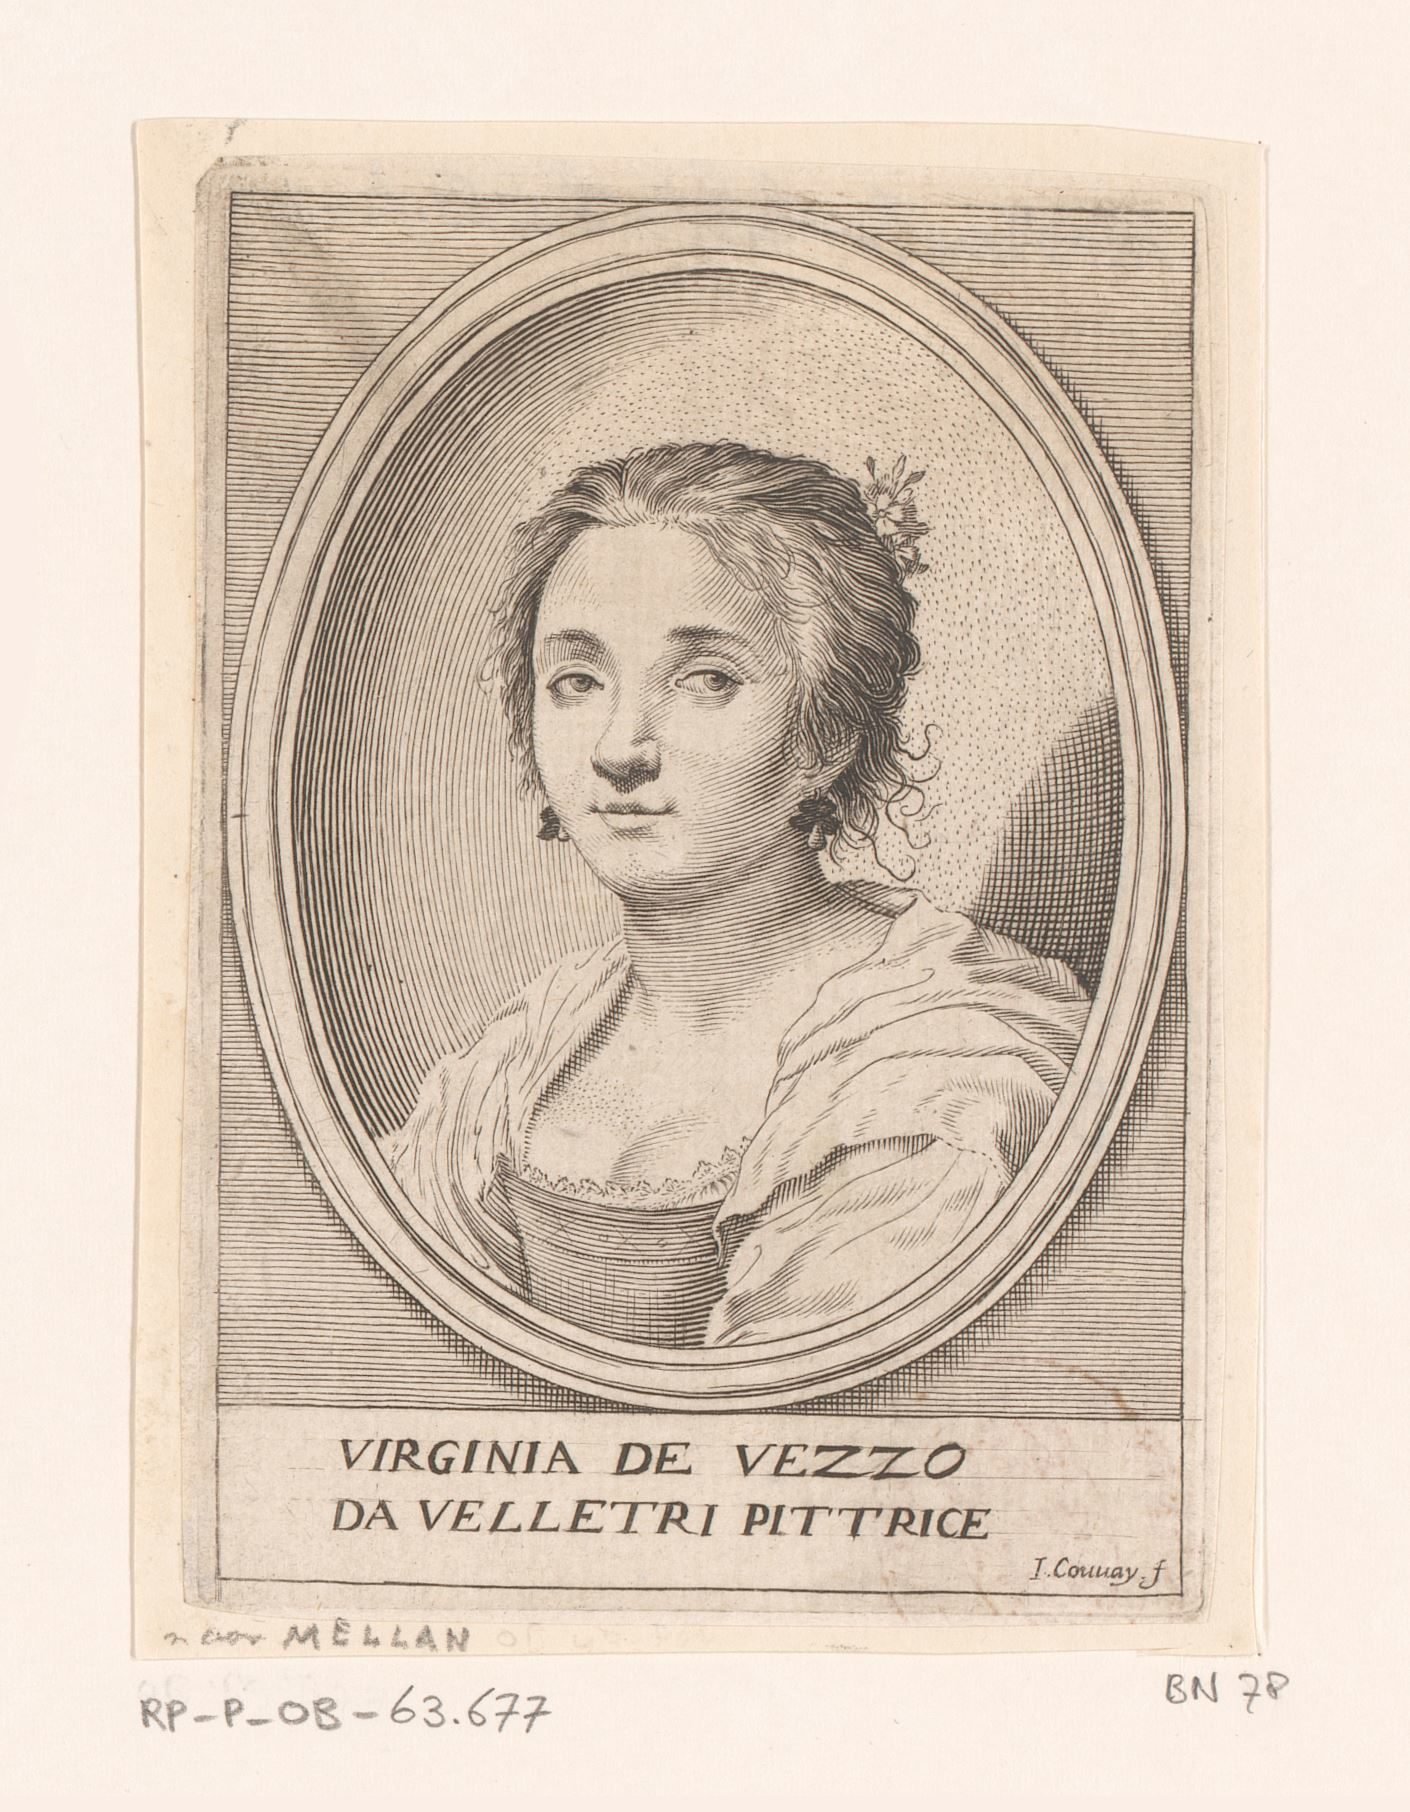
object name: print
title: Virginia de Vezzo da Velletri Pittrice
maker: jean couvay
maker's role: print maker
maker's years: 1622-1680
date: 1632-1675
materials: paper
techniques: engraving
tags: paris, painter, virginia vezzi, historical persons, portrait, self-portrait of artist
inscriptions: collector's mark: Lugt 240